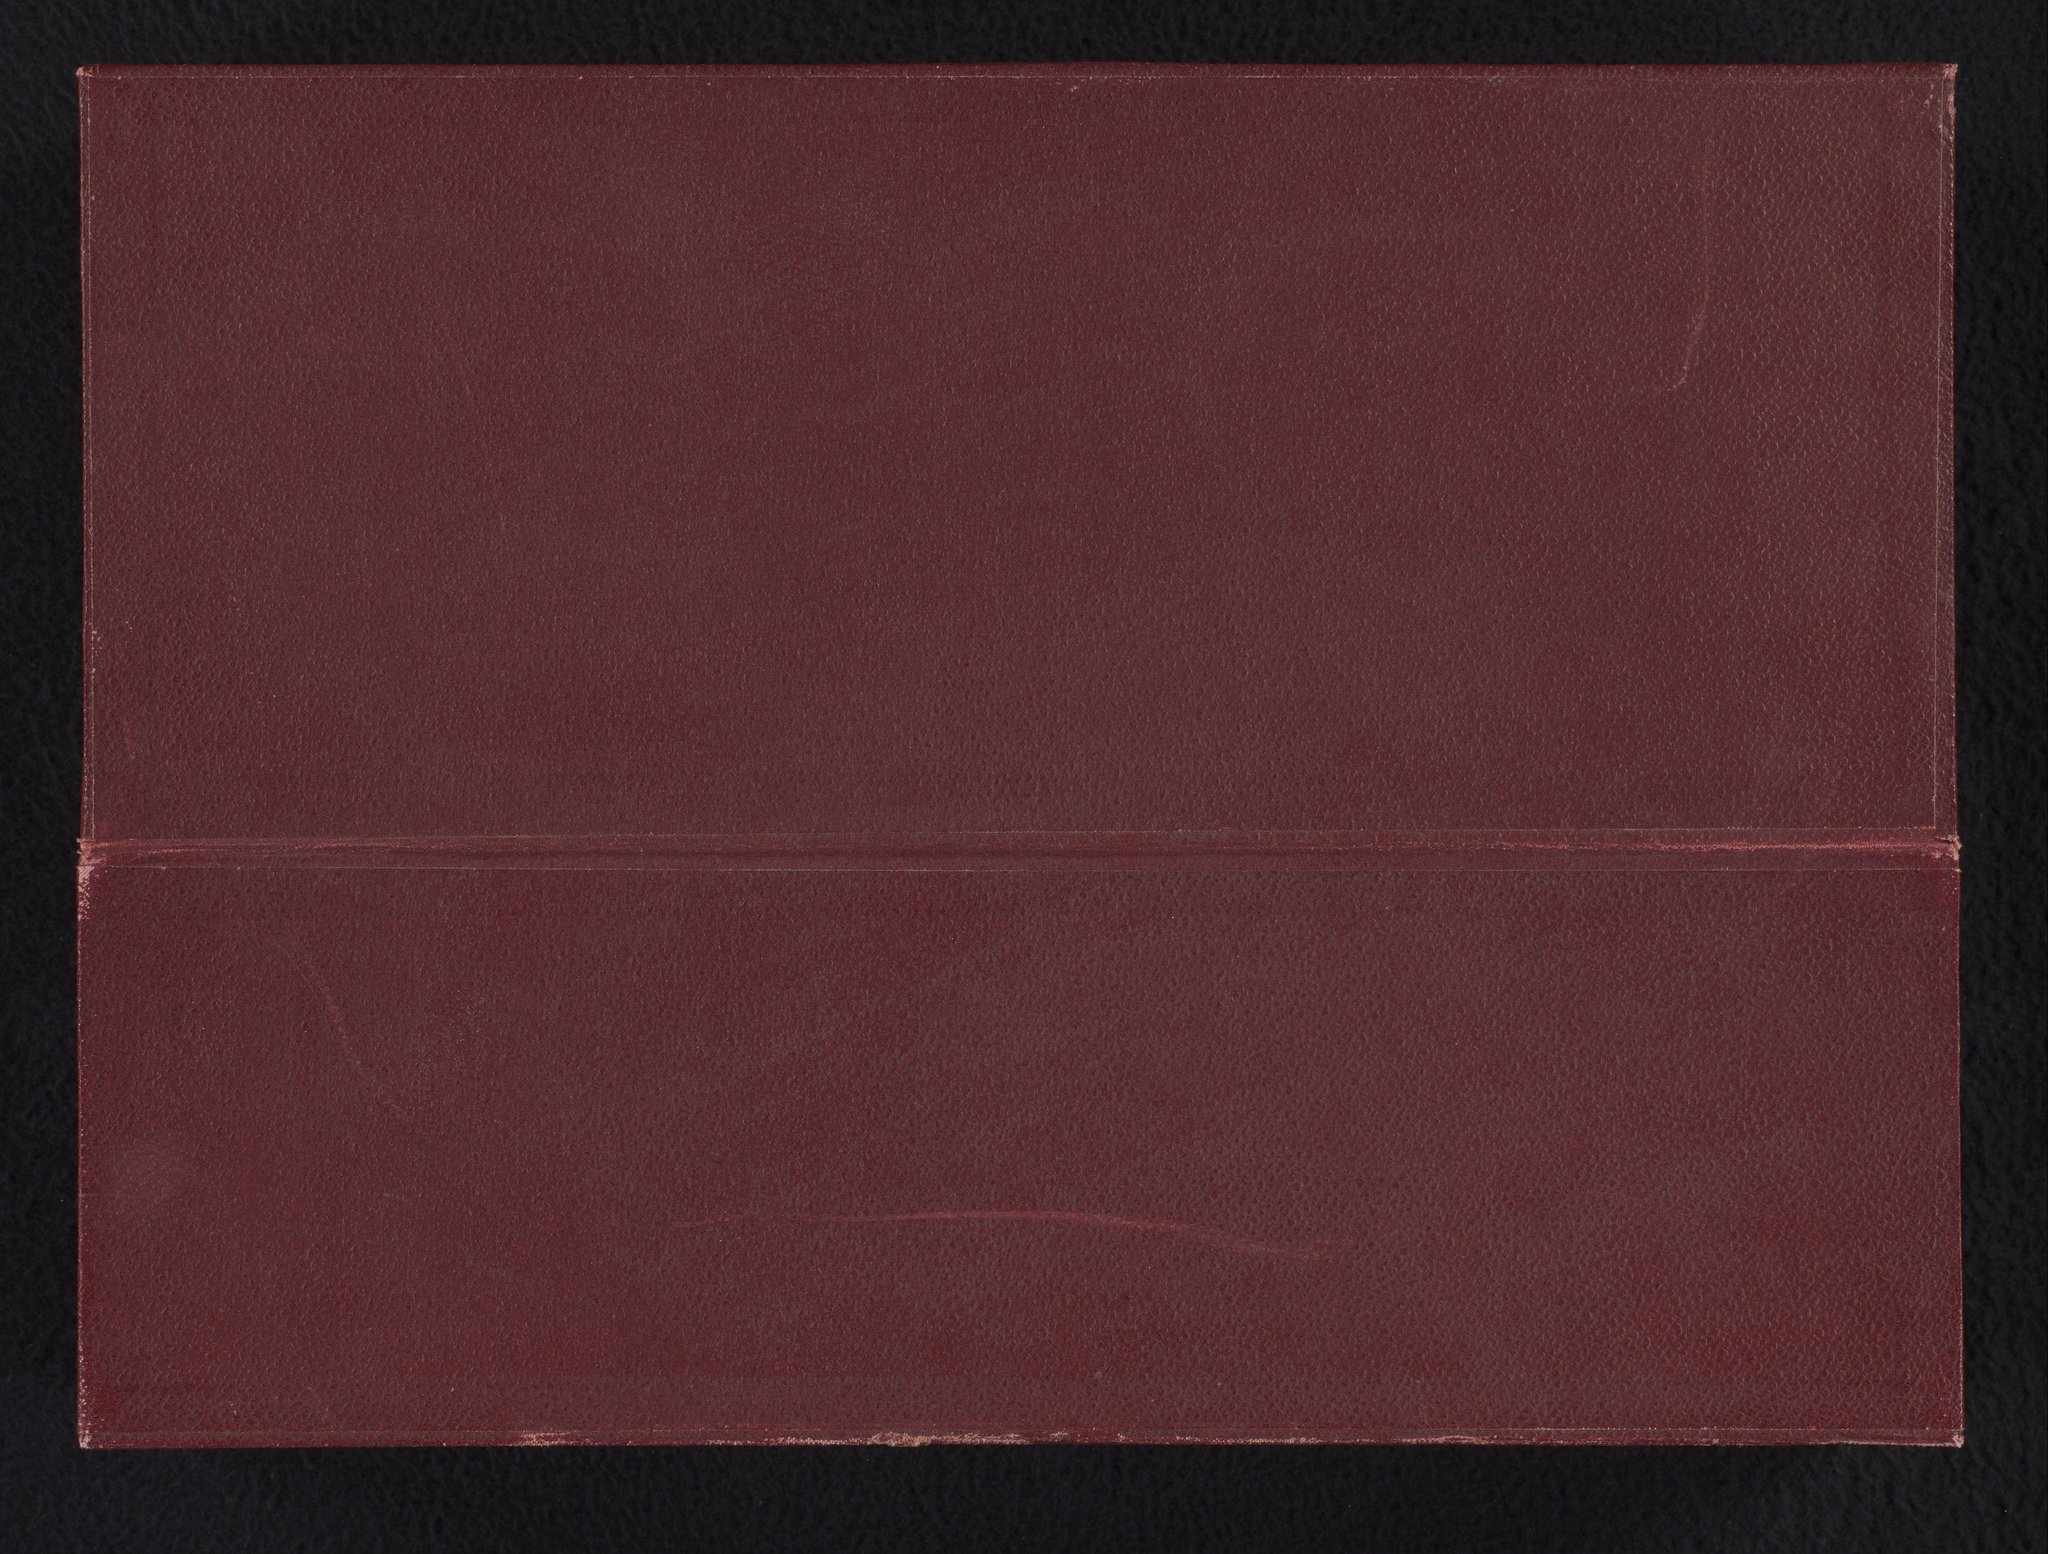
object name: wrapper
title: Omslag voor 68 foto's en fotomechanische afdrukken van Griekenland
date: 1895-1915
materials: cardboard, leather, linen, paper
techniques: gold embossing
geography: greece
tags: architectural detail, landscape with ruins, piece of sculpture, reproduction of a piece of sculpture, temple, shrine ~ greek religion